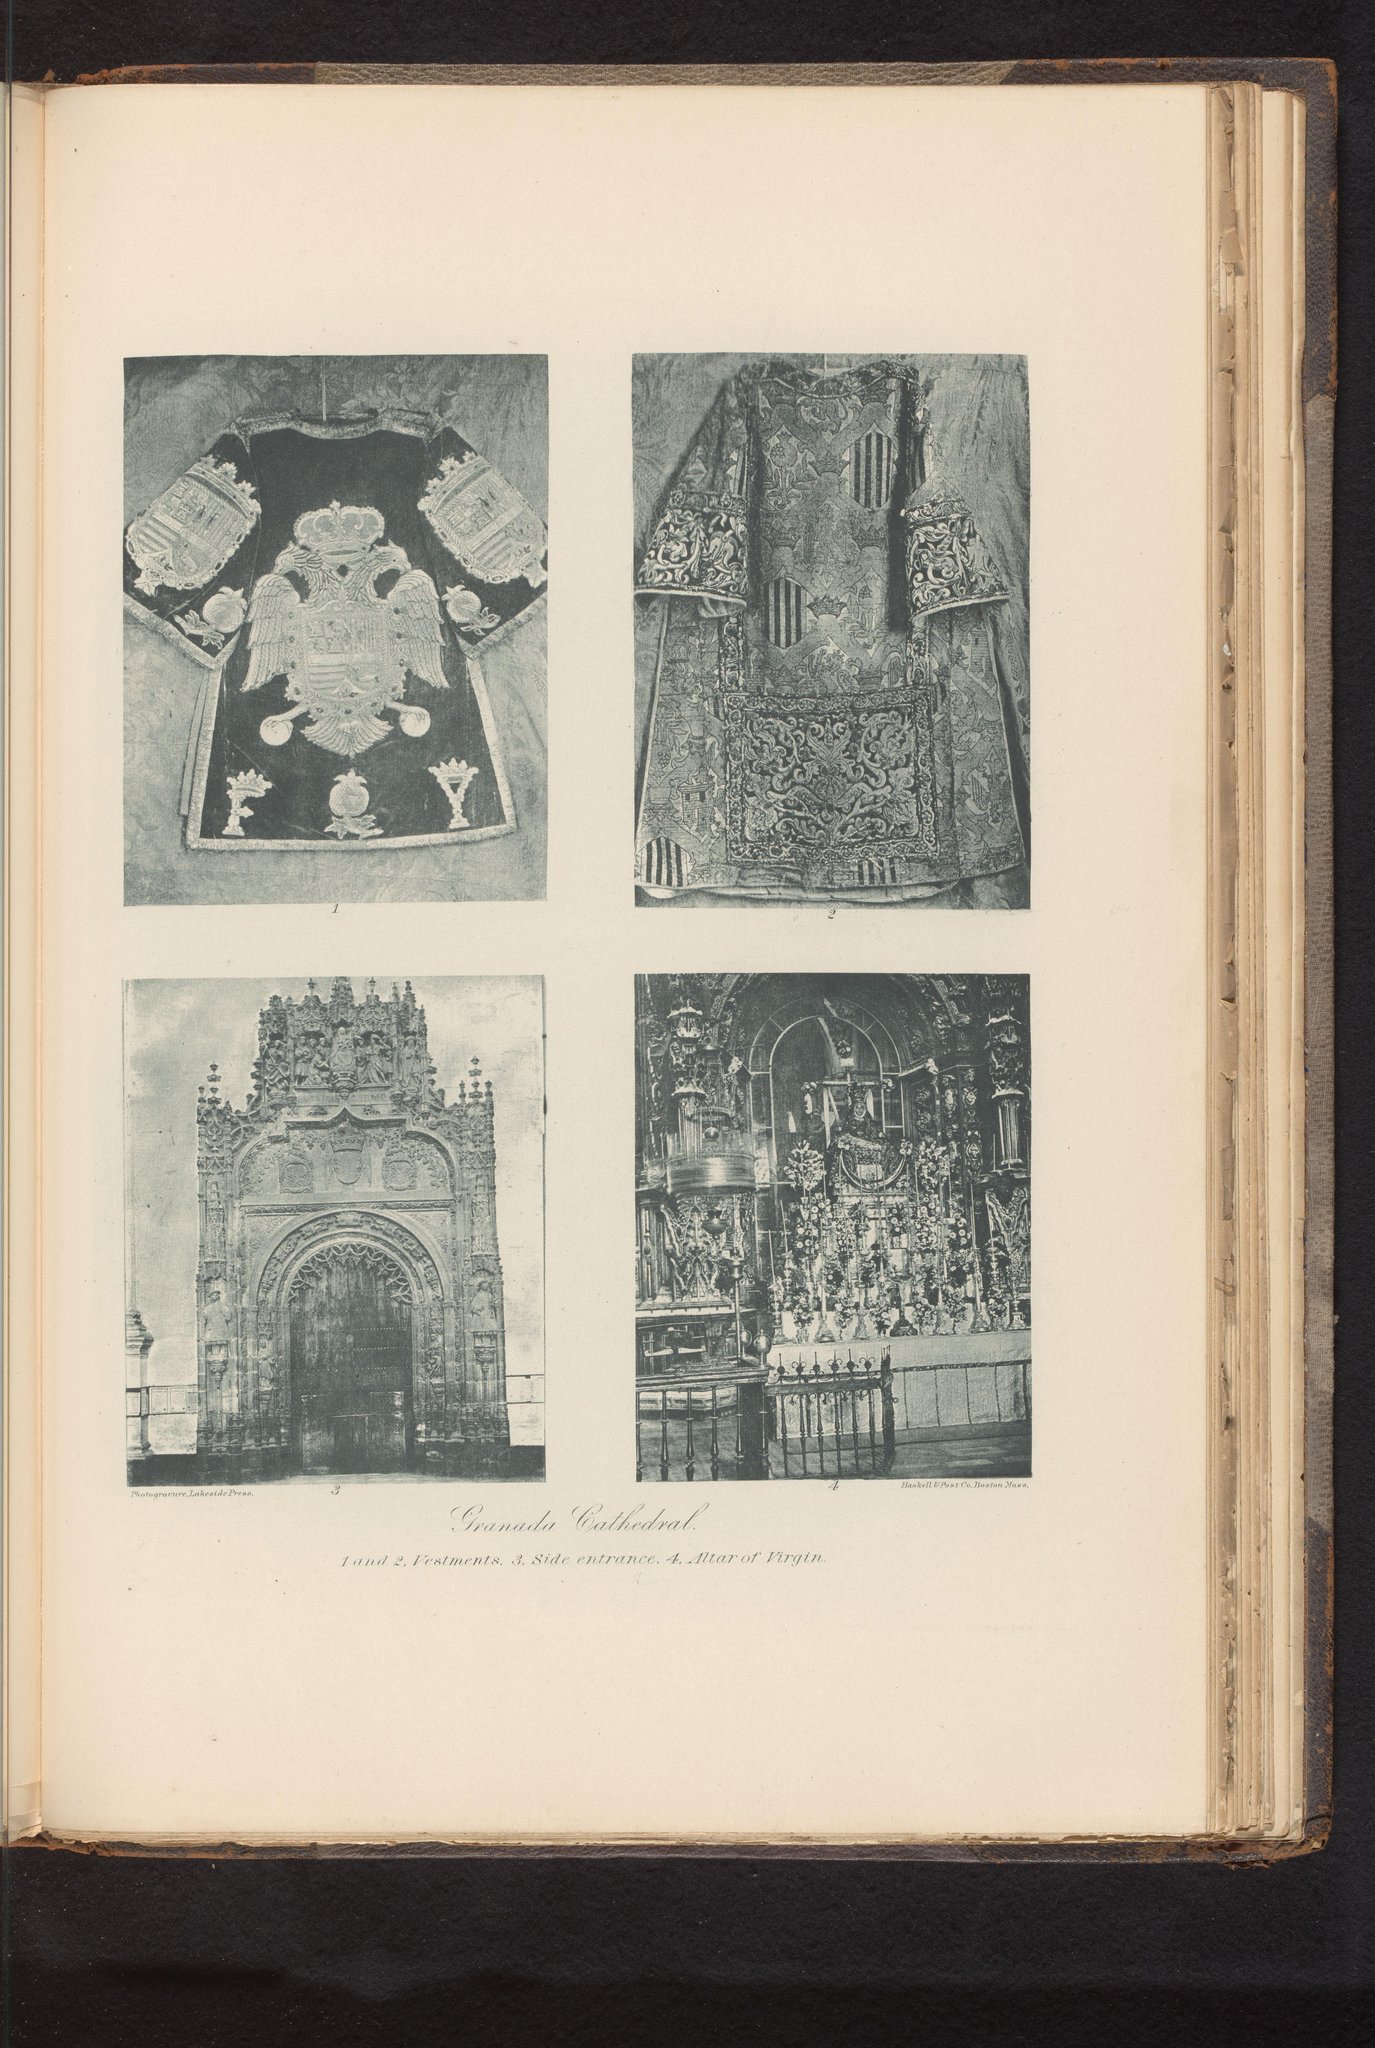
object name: page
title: Vier details van de kathedraal van Granada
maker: Anonymous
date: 1881-1886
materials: paper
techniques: photograph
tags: parts of church exterior and annexes: portal, liturgical vestments, canonicals, altar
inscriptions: inscription: ‘1 and 2, Vestments. 3, Side entrance. 4, Altar of Virgin.’